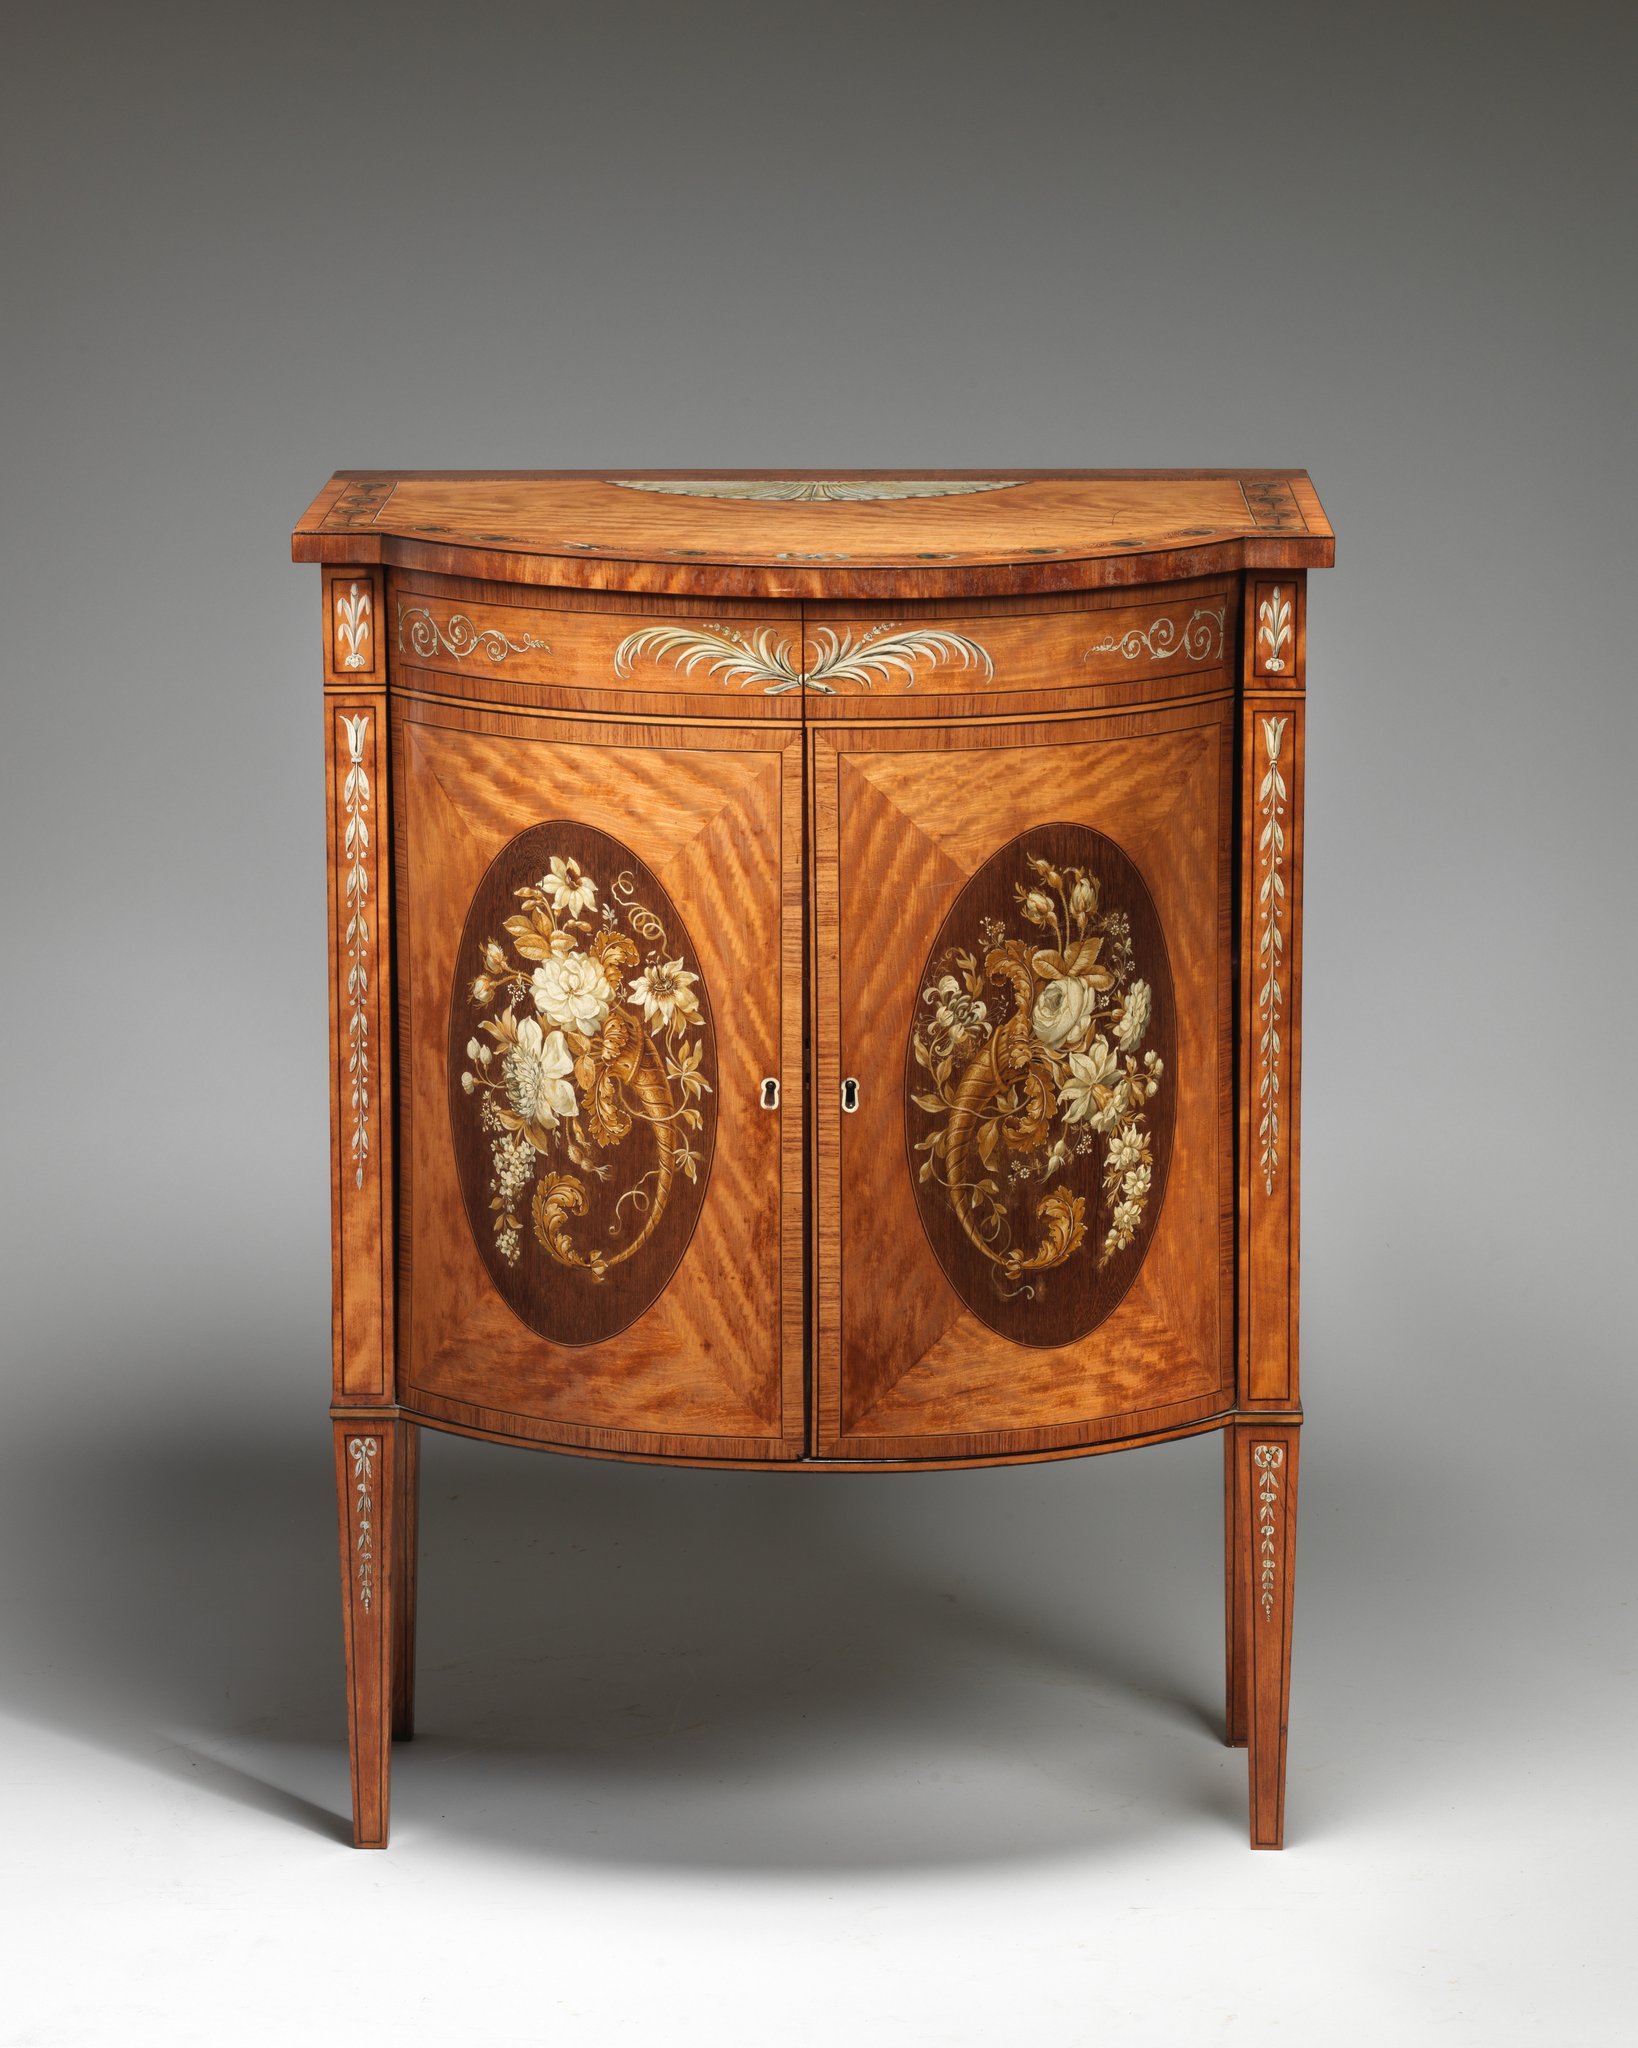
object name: cabinet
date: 1790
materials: wood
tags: flowers